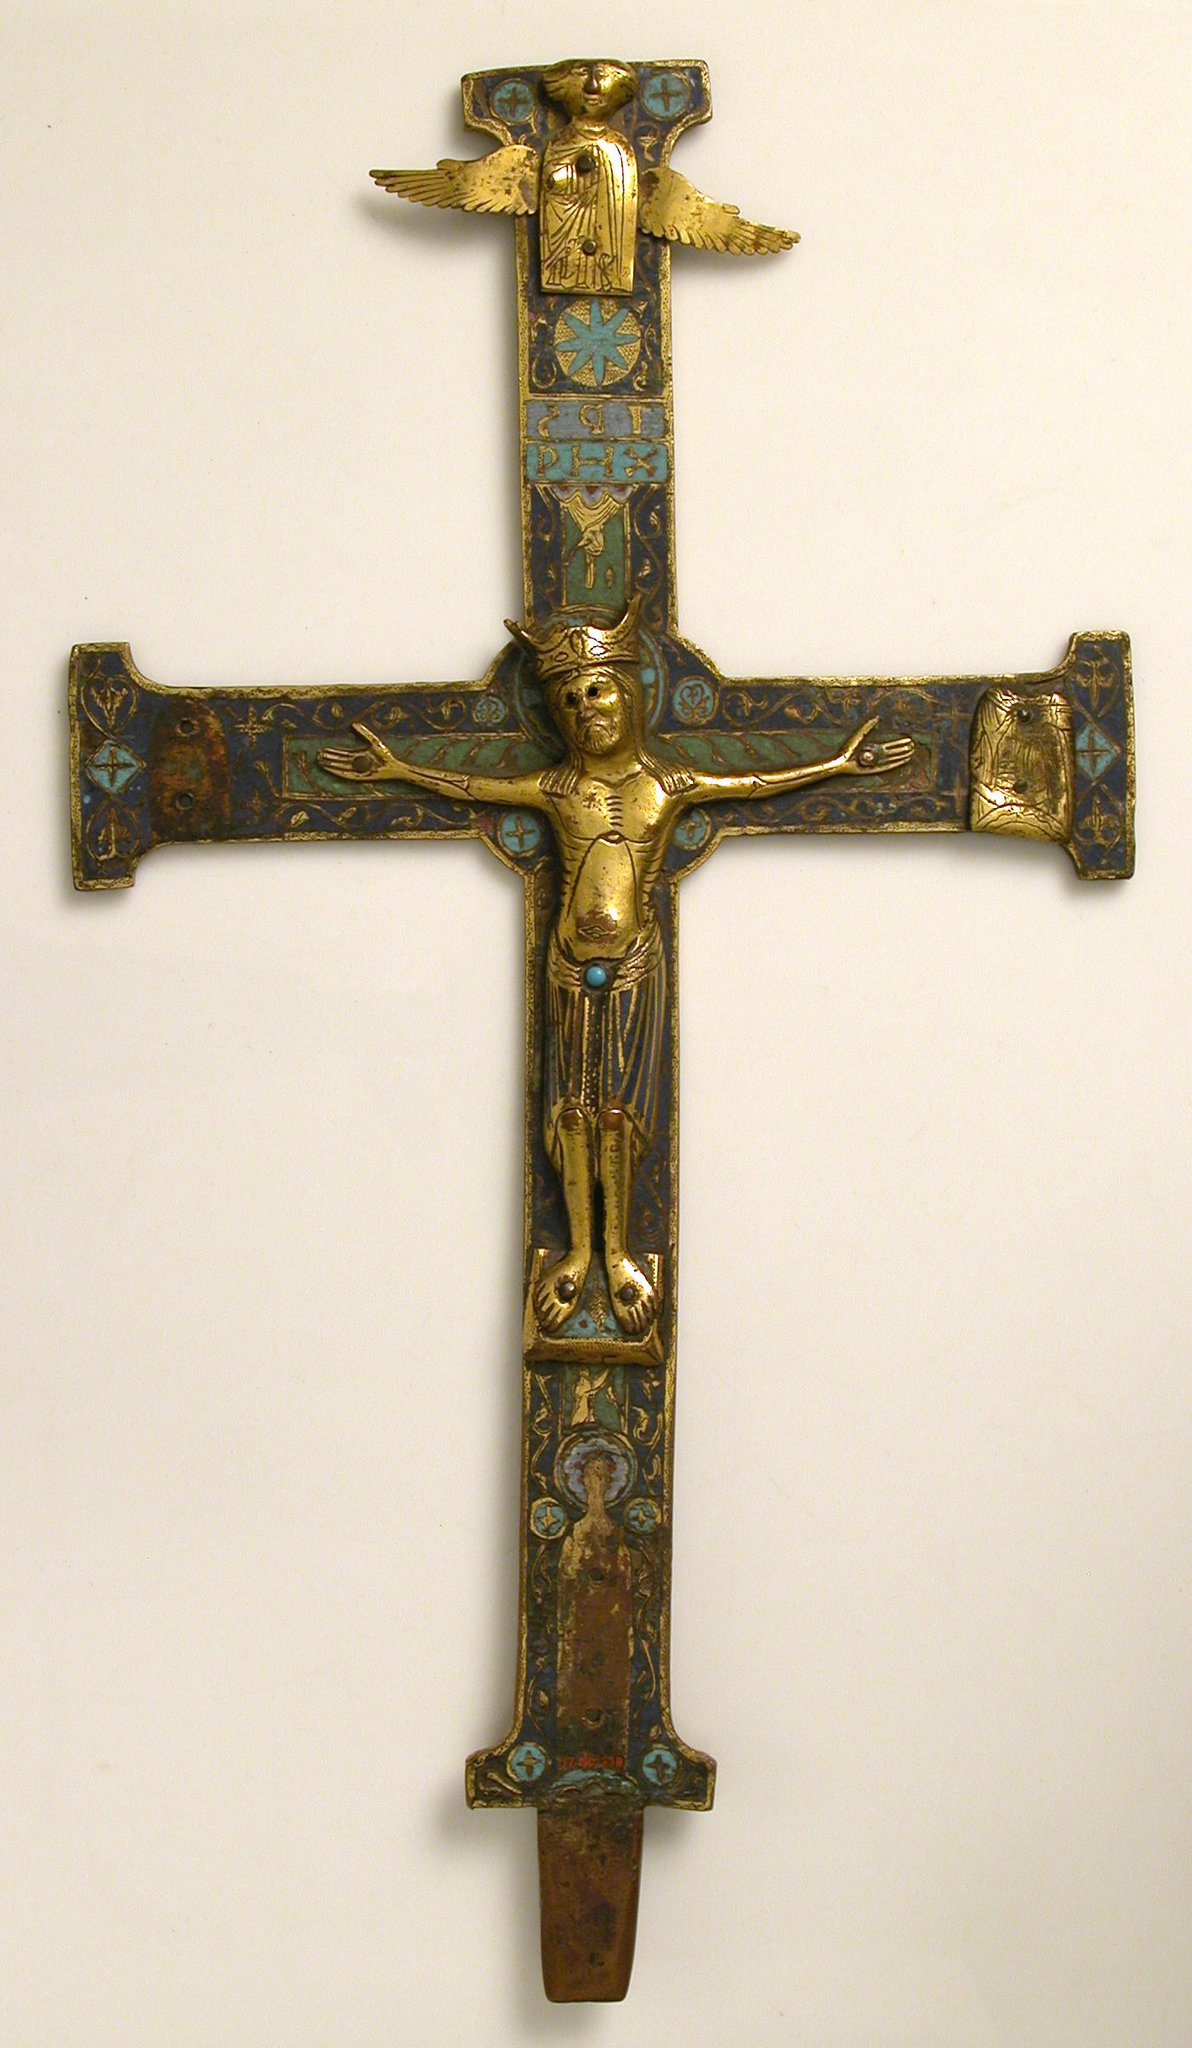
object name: crucifix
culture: french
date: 1201-1300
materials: gilt copper, enamel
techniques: enamel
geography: france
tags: angels,christ